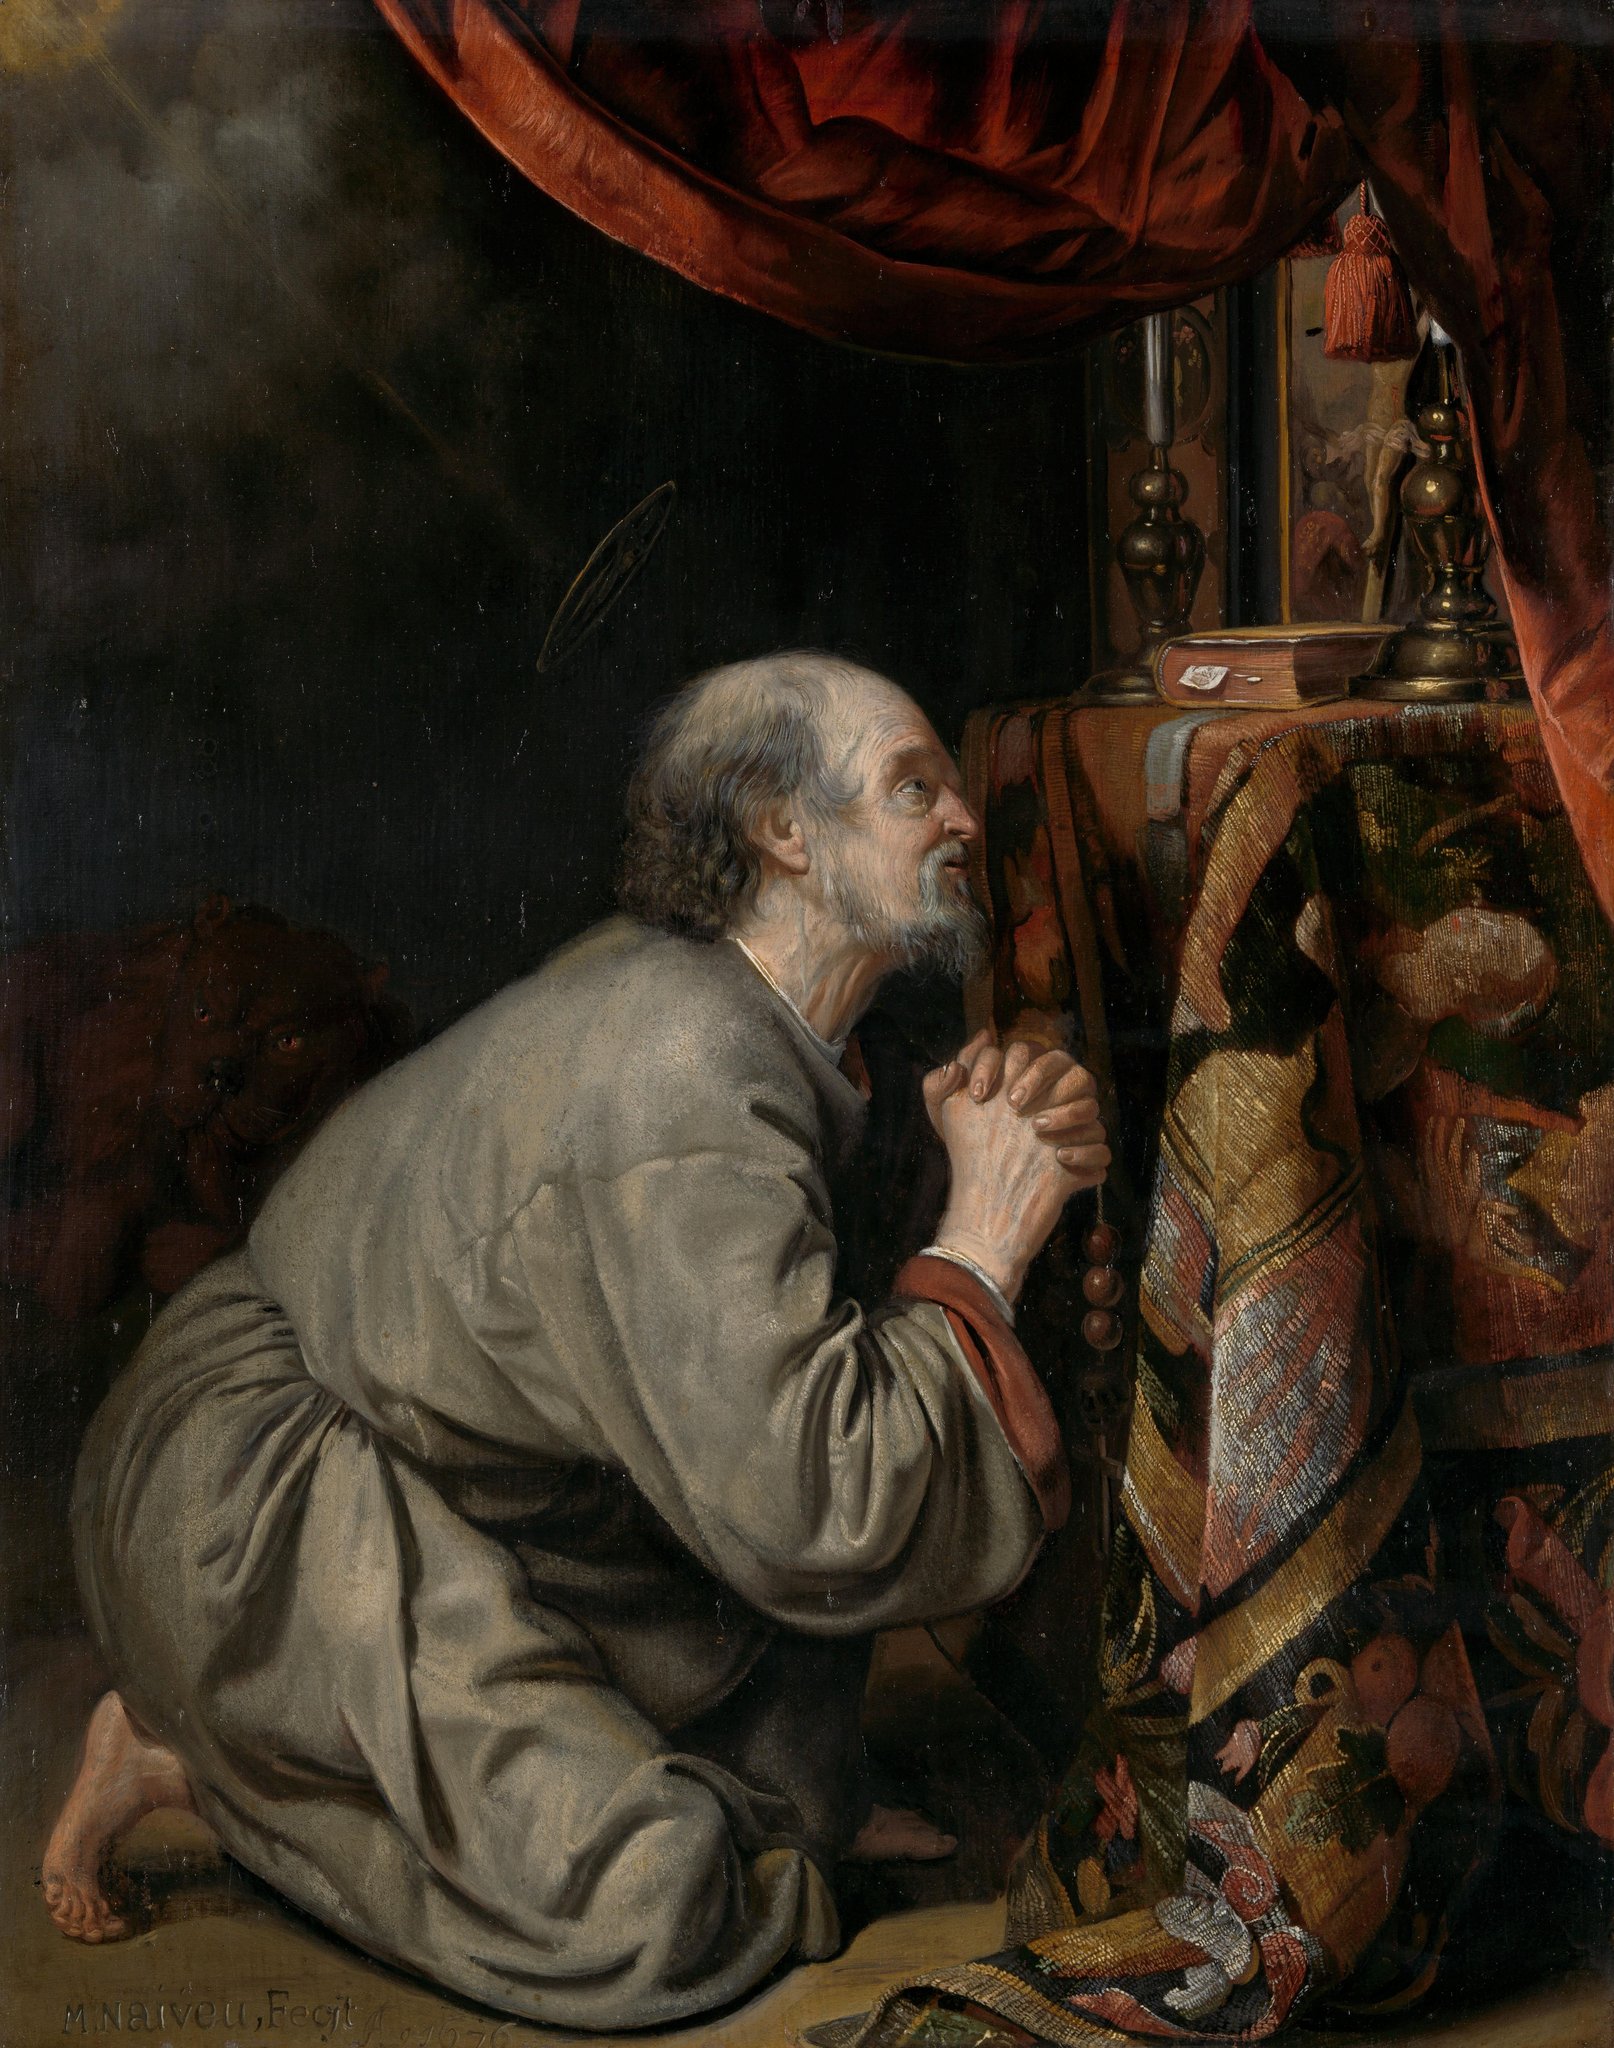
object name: painting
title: St. Jerome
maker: matthijs naiveu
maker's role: painter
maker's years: 1647-1726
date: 1676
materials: oil, panel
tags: the monk and hermit jerome (hieronymus); possible attributes: book, cardinal's hat, crucifix, hour-glass, lion, skull, stone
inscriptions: signature and date: ‘M. Naiveu Fecit Aº 1676’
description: De heilige Hieronymus. Geknield biddend, met tranen in de ogen, voor een kruisbeeld op een altaar gemaakt van een tafel bedekt met een Perzisch tapijt, twee kaarsen, een boek en een schilderijtje. In de handen een rozenkrans.